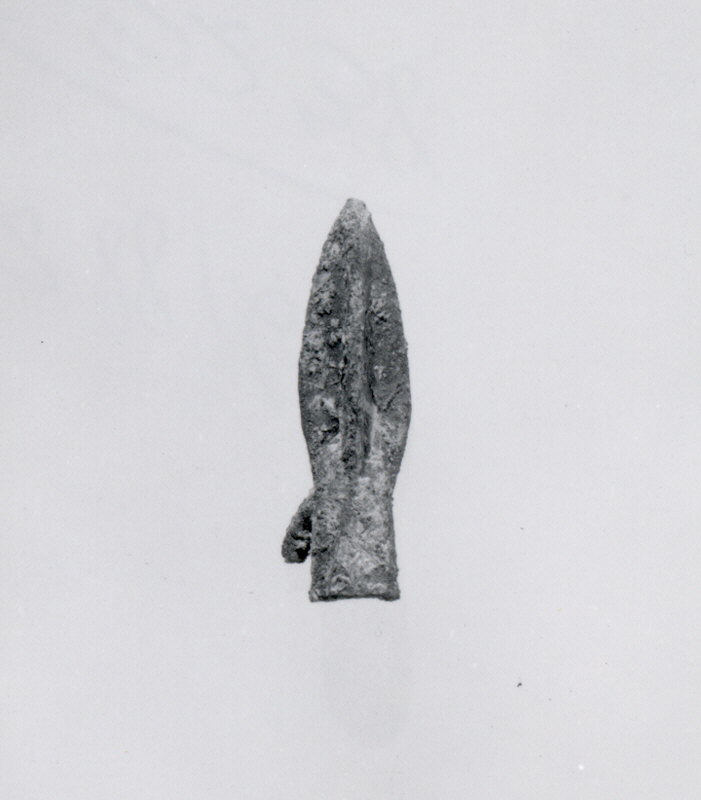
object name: arrowhead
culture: parthian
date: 1-100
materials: bronze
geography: iran